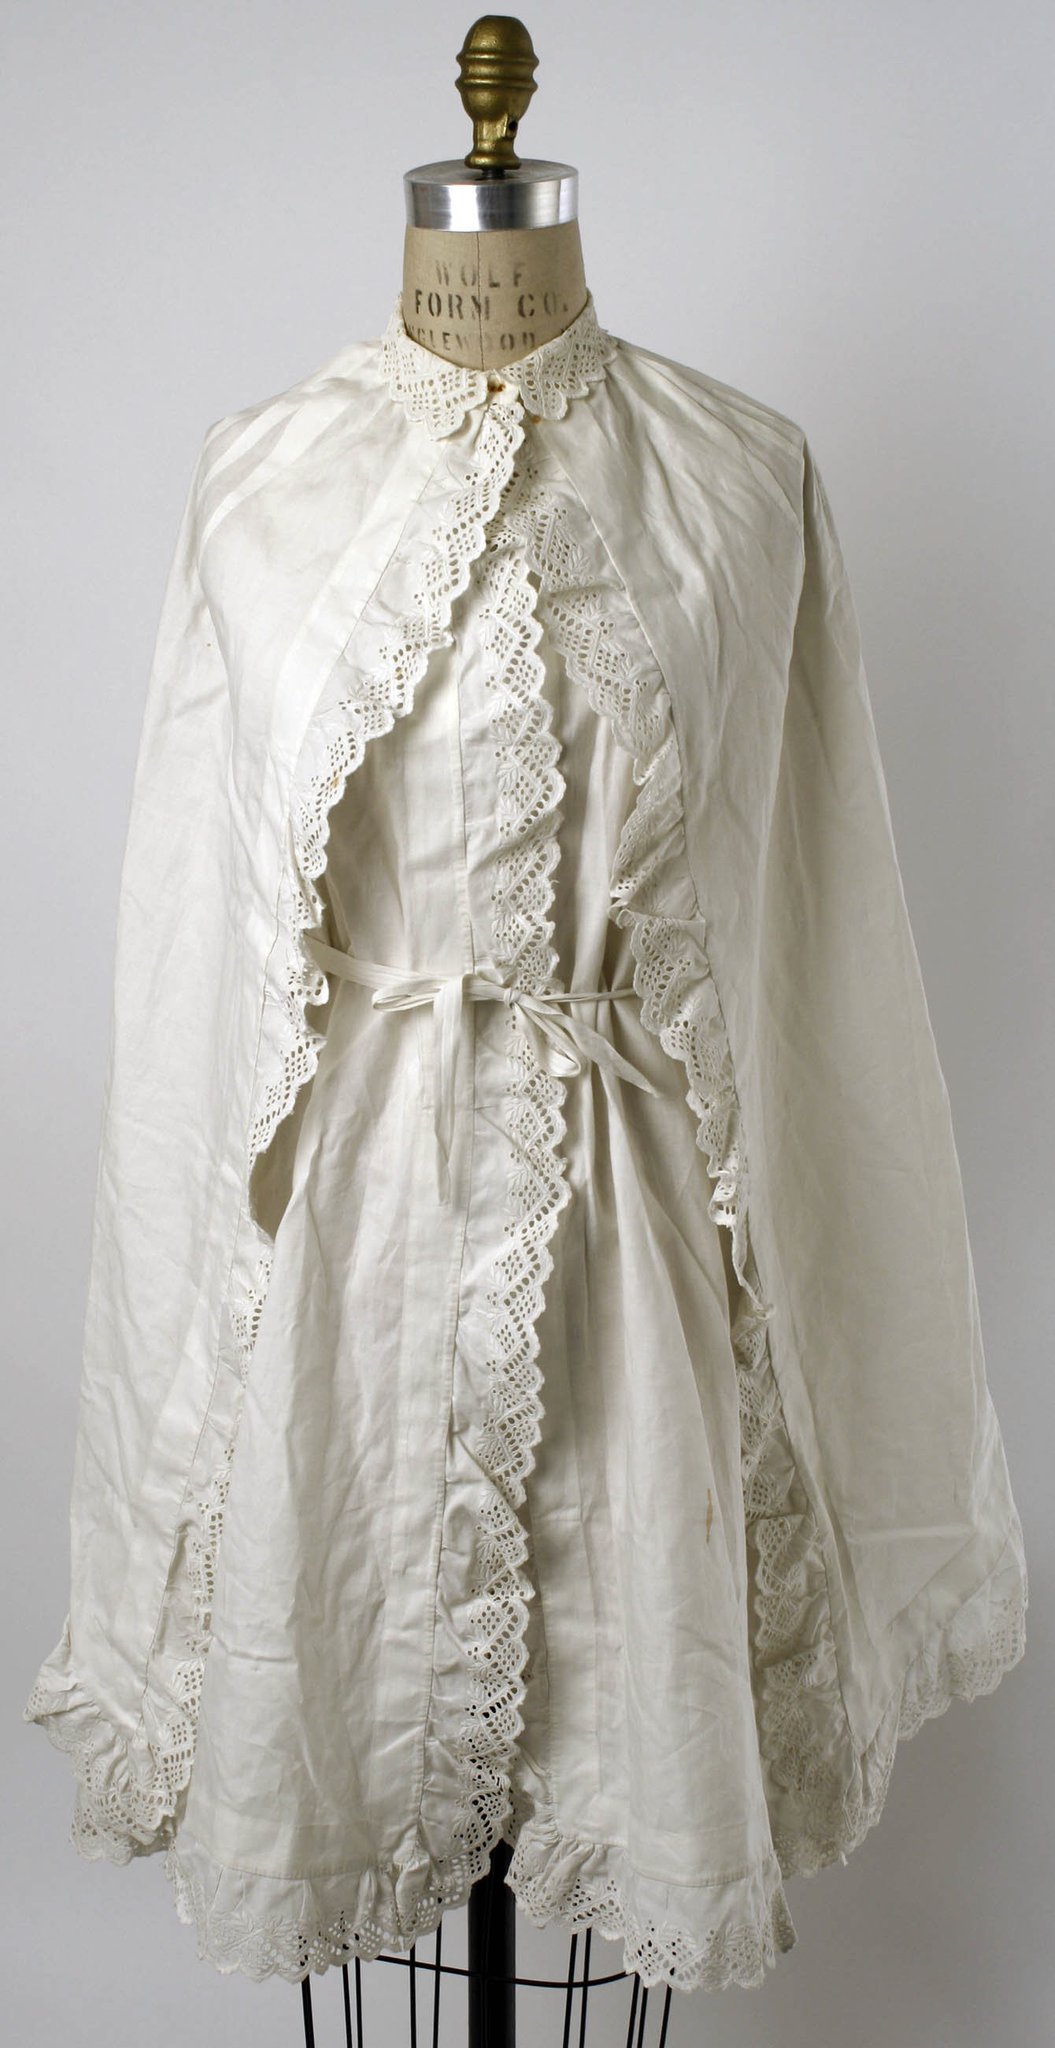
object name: peignoir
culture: hungarian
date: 1880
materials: cotton